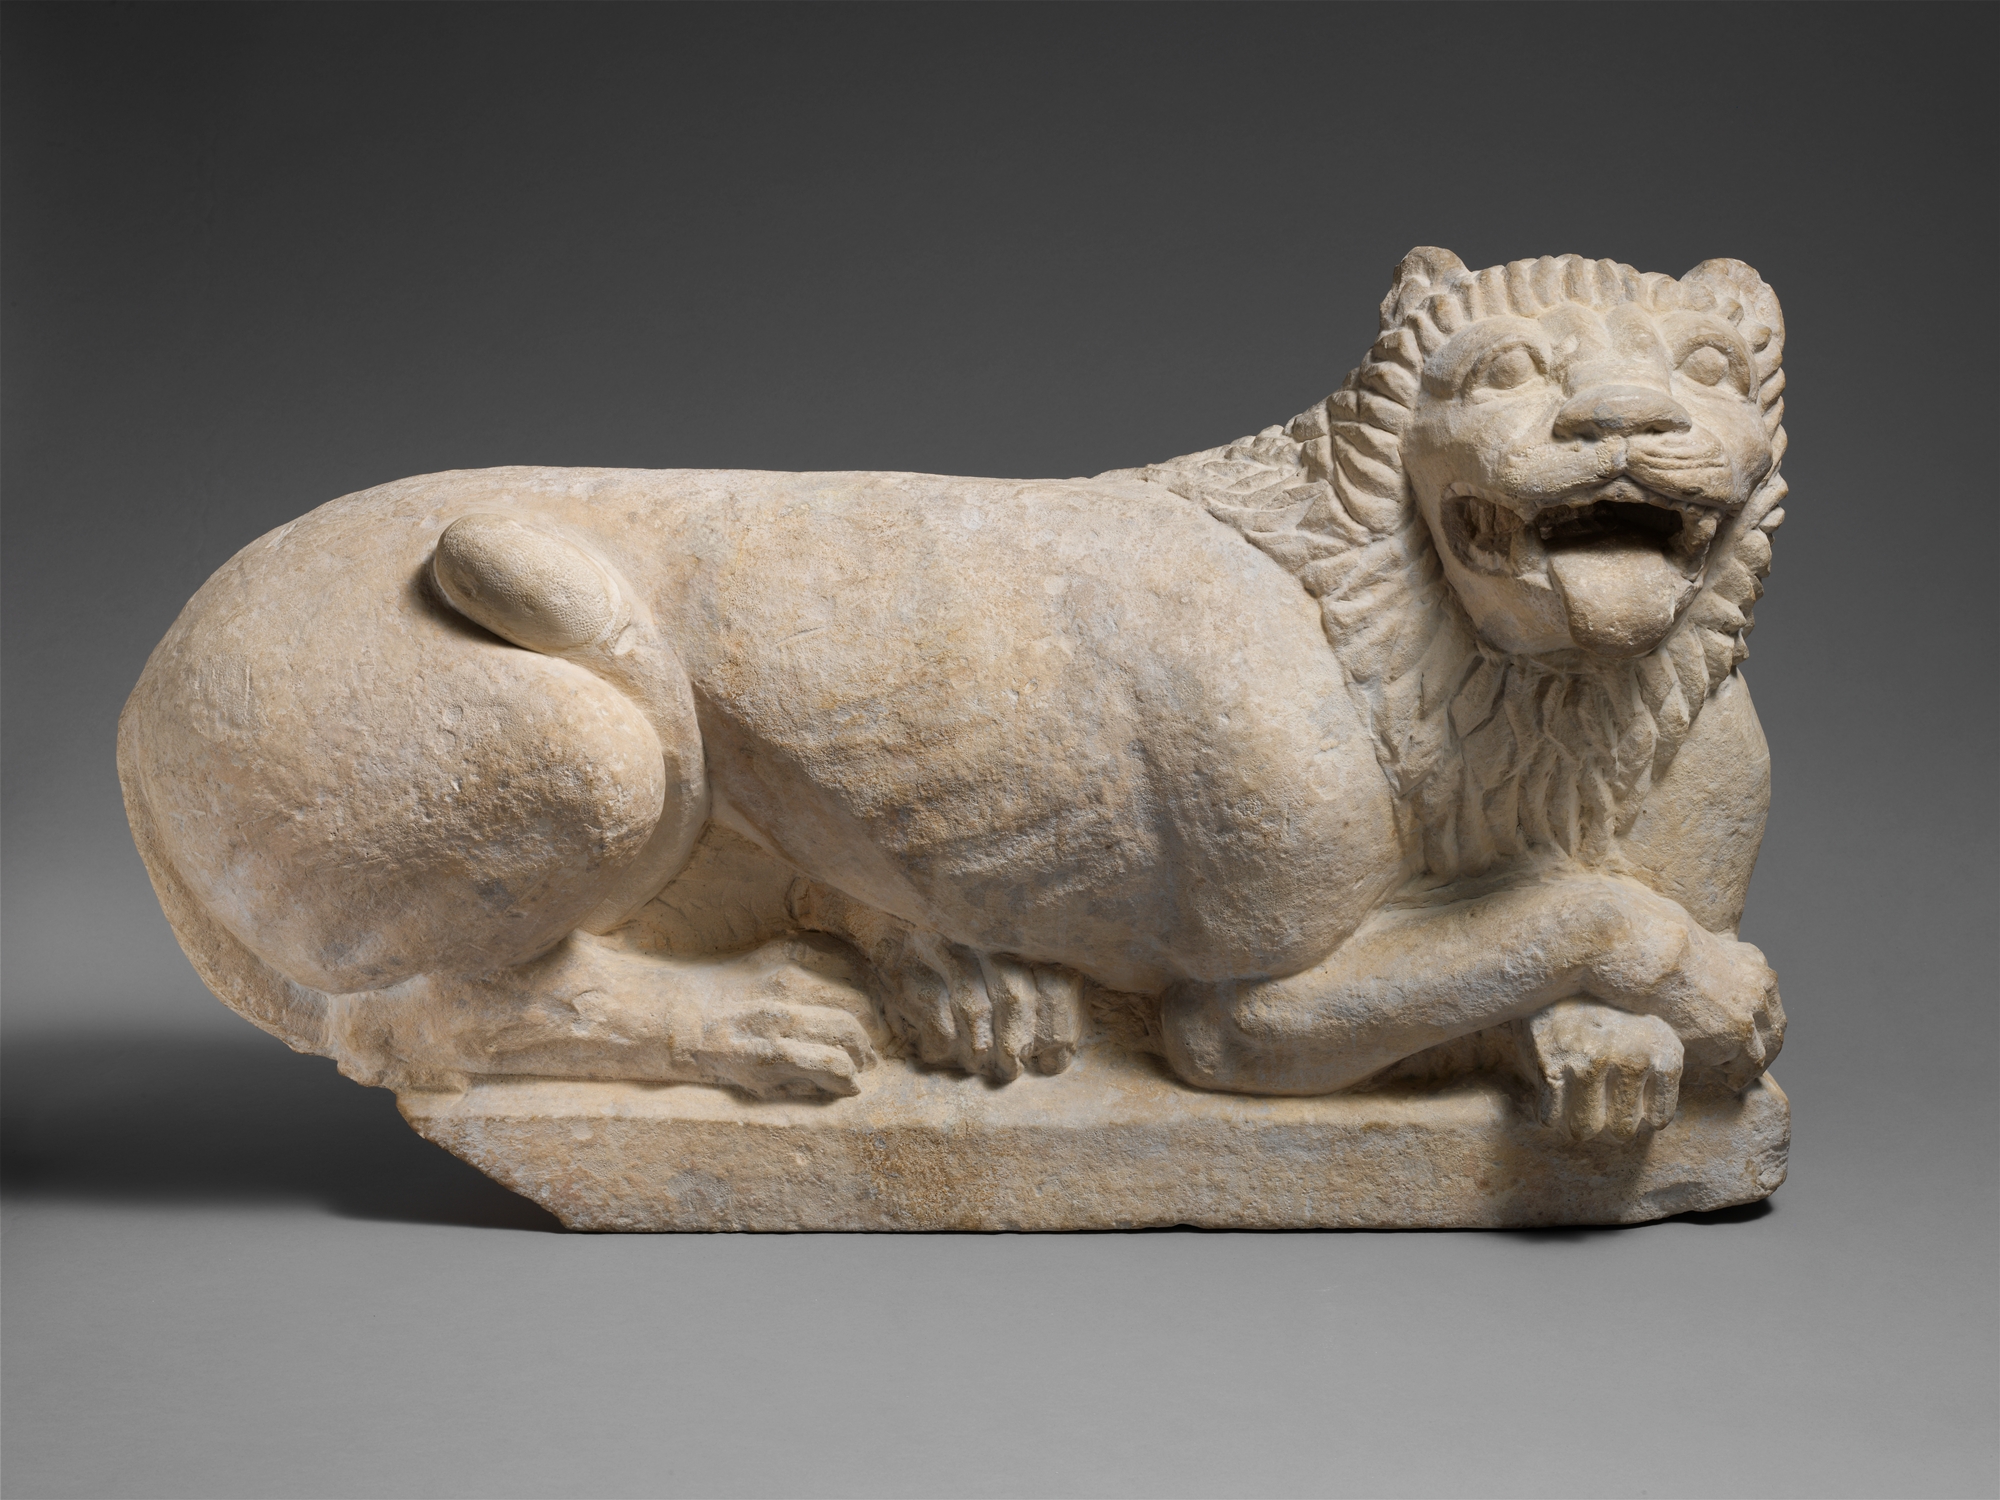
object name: statue, lion recumbent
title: Limestone recumbant lion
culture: cypriot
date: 450-401 BCE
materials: limestone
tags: lions